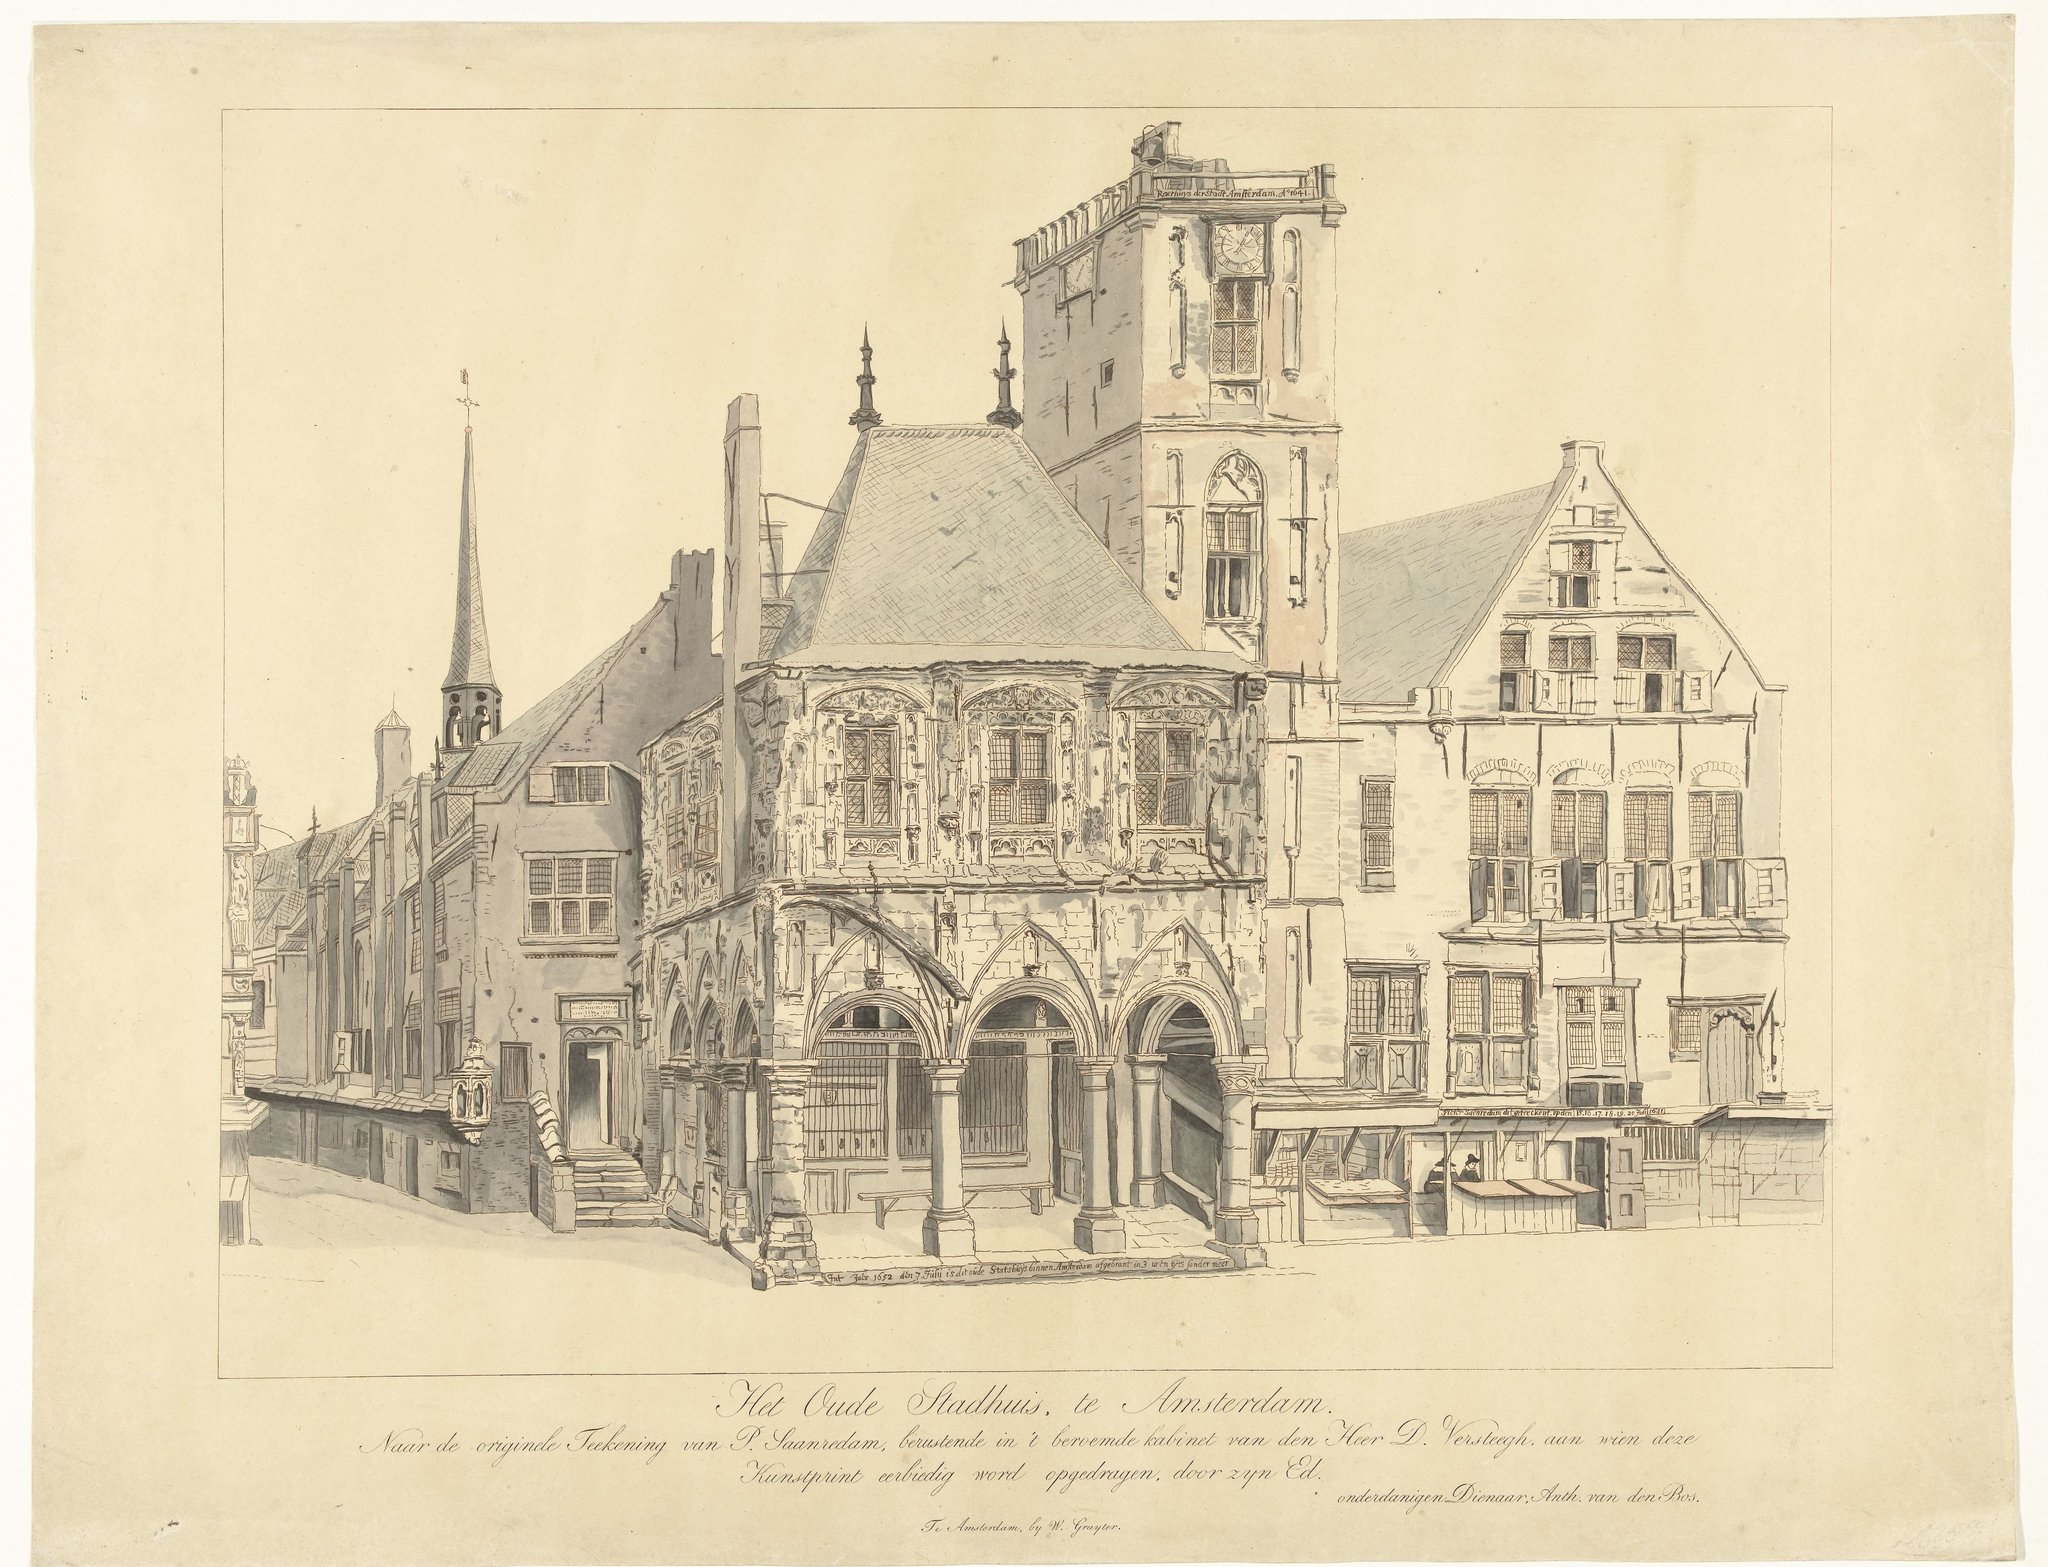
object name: print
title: Het Oude Stadhuis van Amsterdam, 1641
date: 1775-1822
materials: paper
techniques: etching, hand coloring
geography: netherlands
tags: stadhuis van amsterdam (14e eeuw-1652)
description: Het Oude Stadhuis van Amsterdam, naar de tekening van 20 juni 1641. Op de stenen van de drempel een inscriptie over het afbranden van het stadhuis op 7 juli 1652.